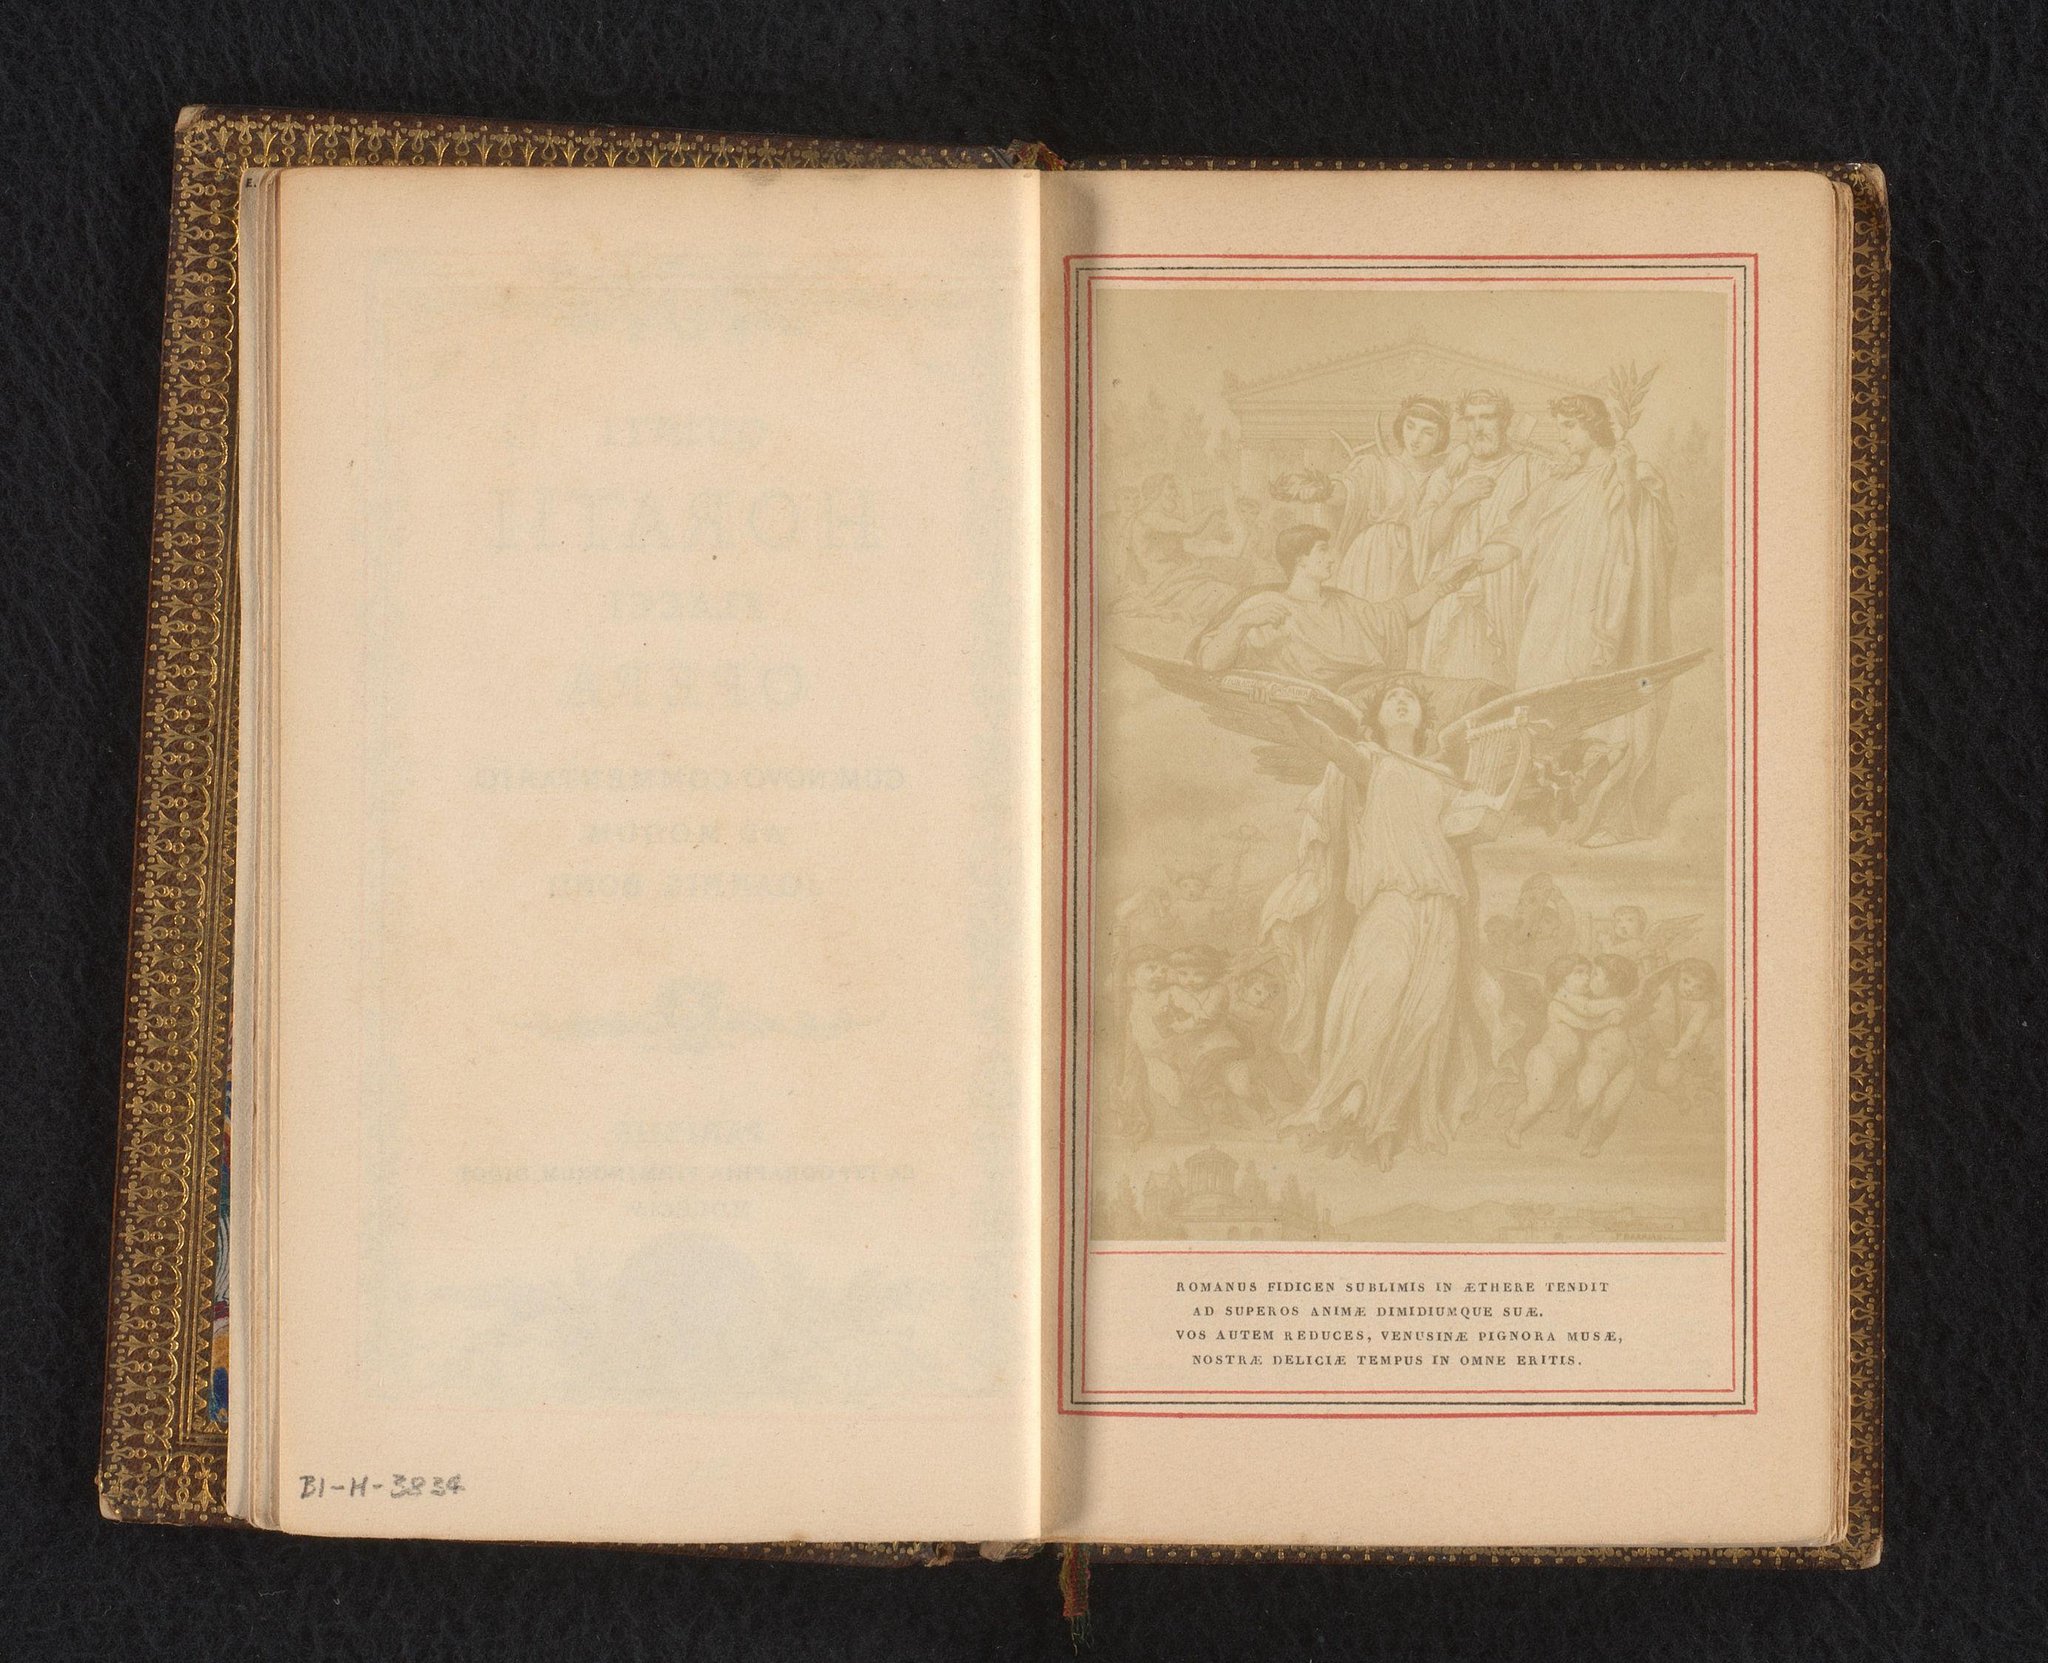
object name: page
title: Fotoreproductie van een illustratie van Horatius met goden en muzen in de wolken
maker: Anonymous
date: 1851-1855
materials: paper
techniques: albumen print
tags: venosa, rome, horatius, fame ~ writer, 'poeta laureatus', angels, journey to heaven, pathway to heaven